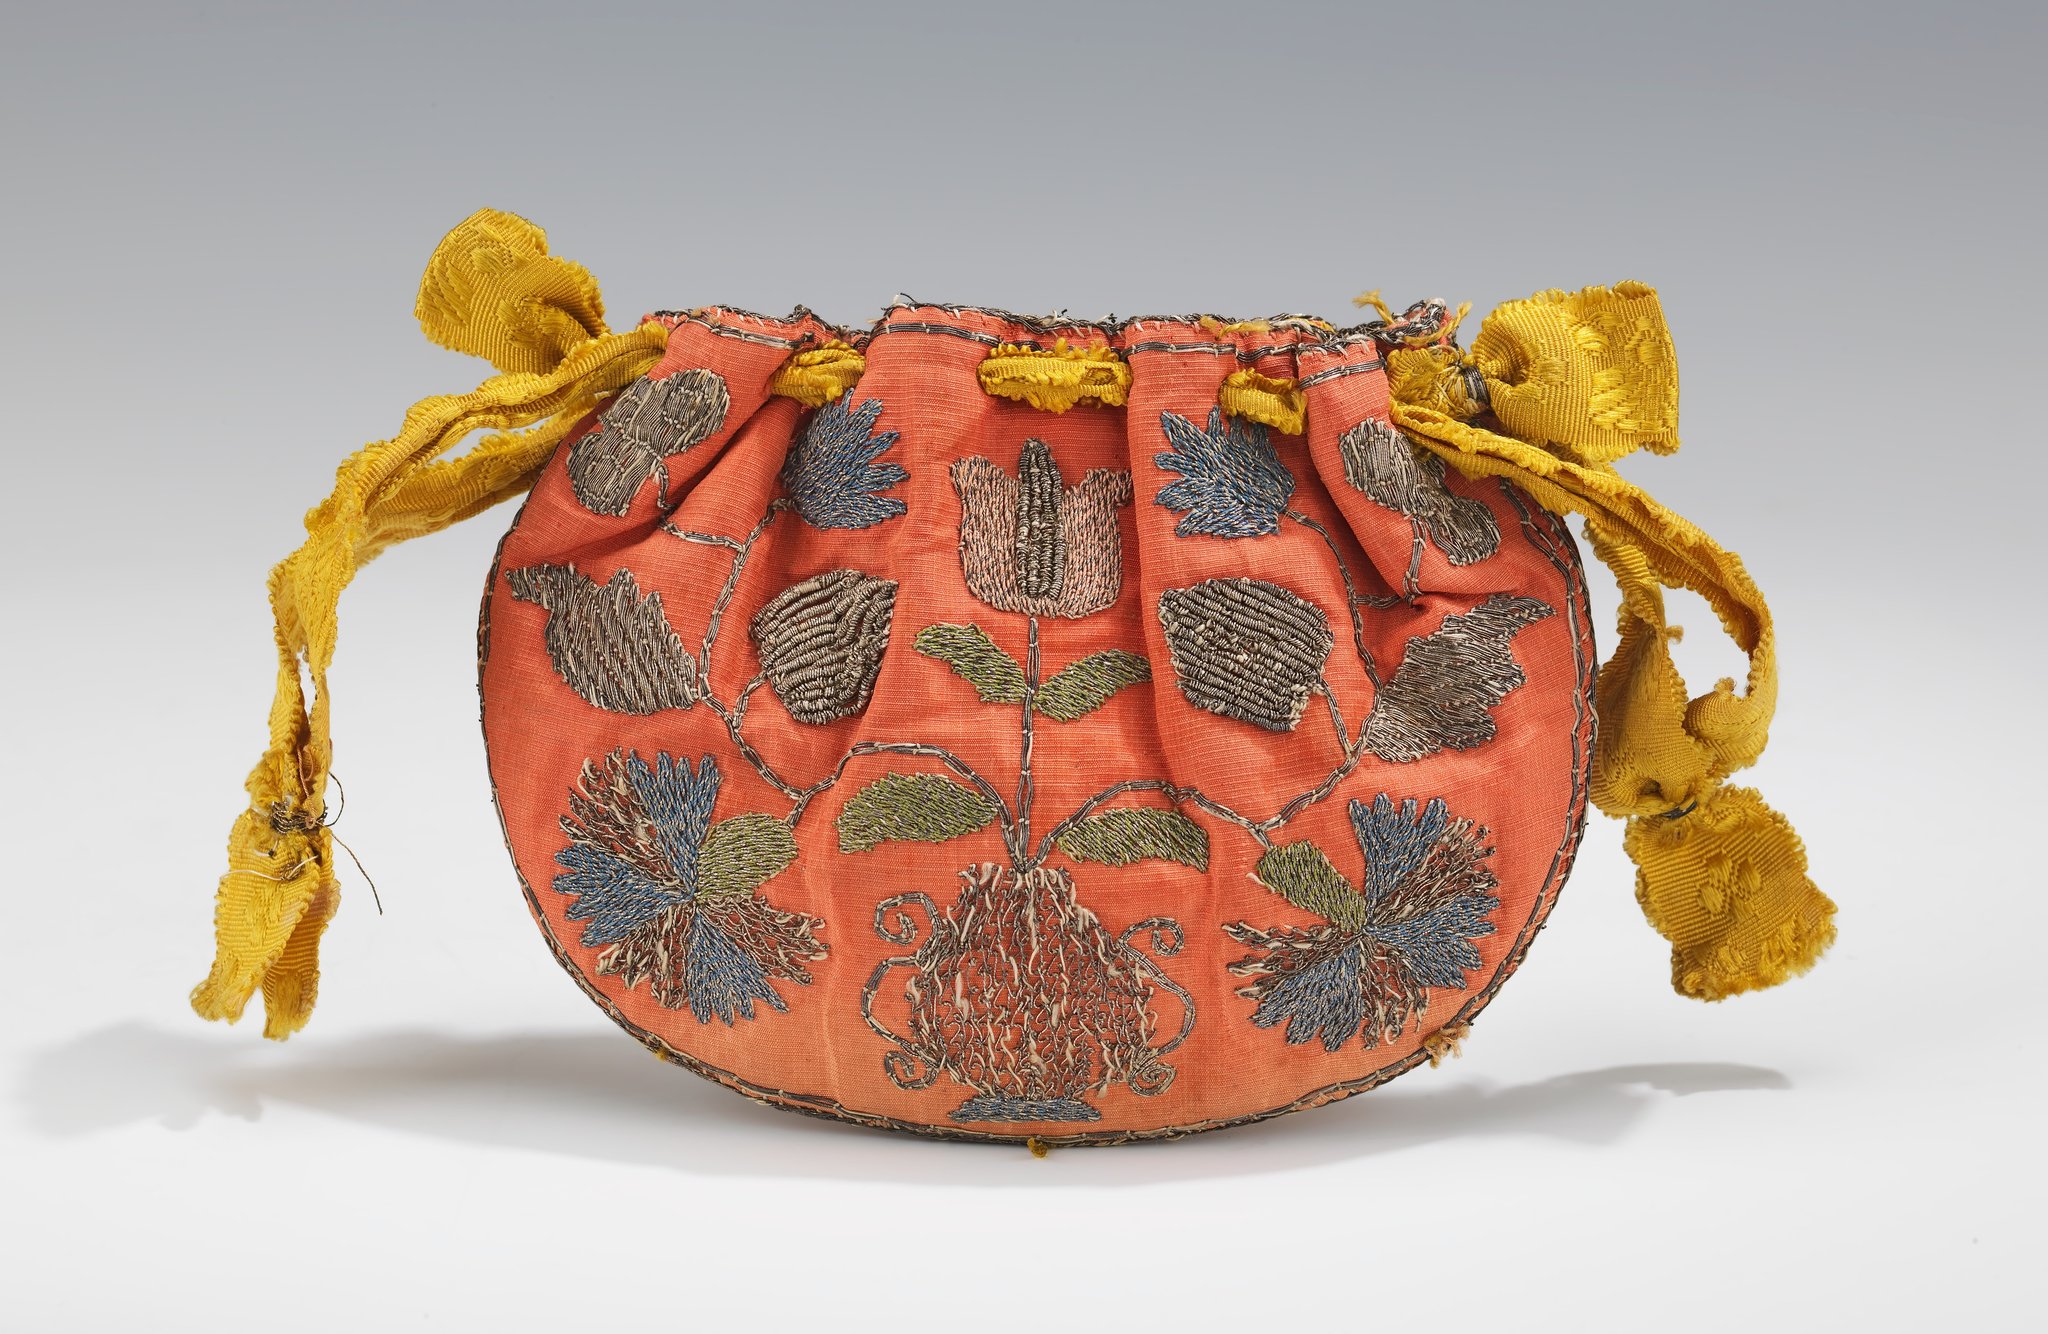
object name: pouch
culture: russian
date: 1701-1733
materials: metal, silk